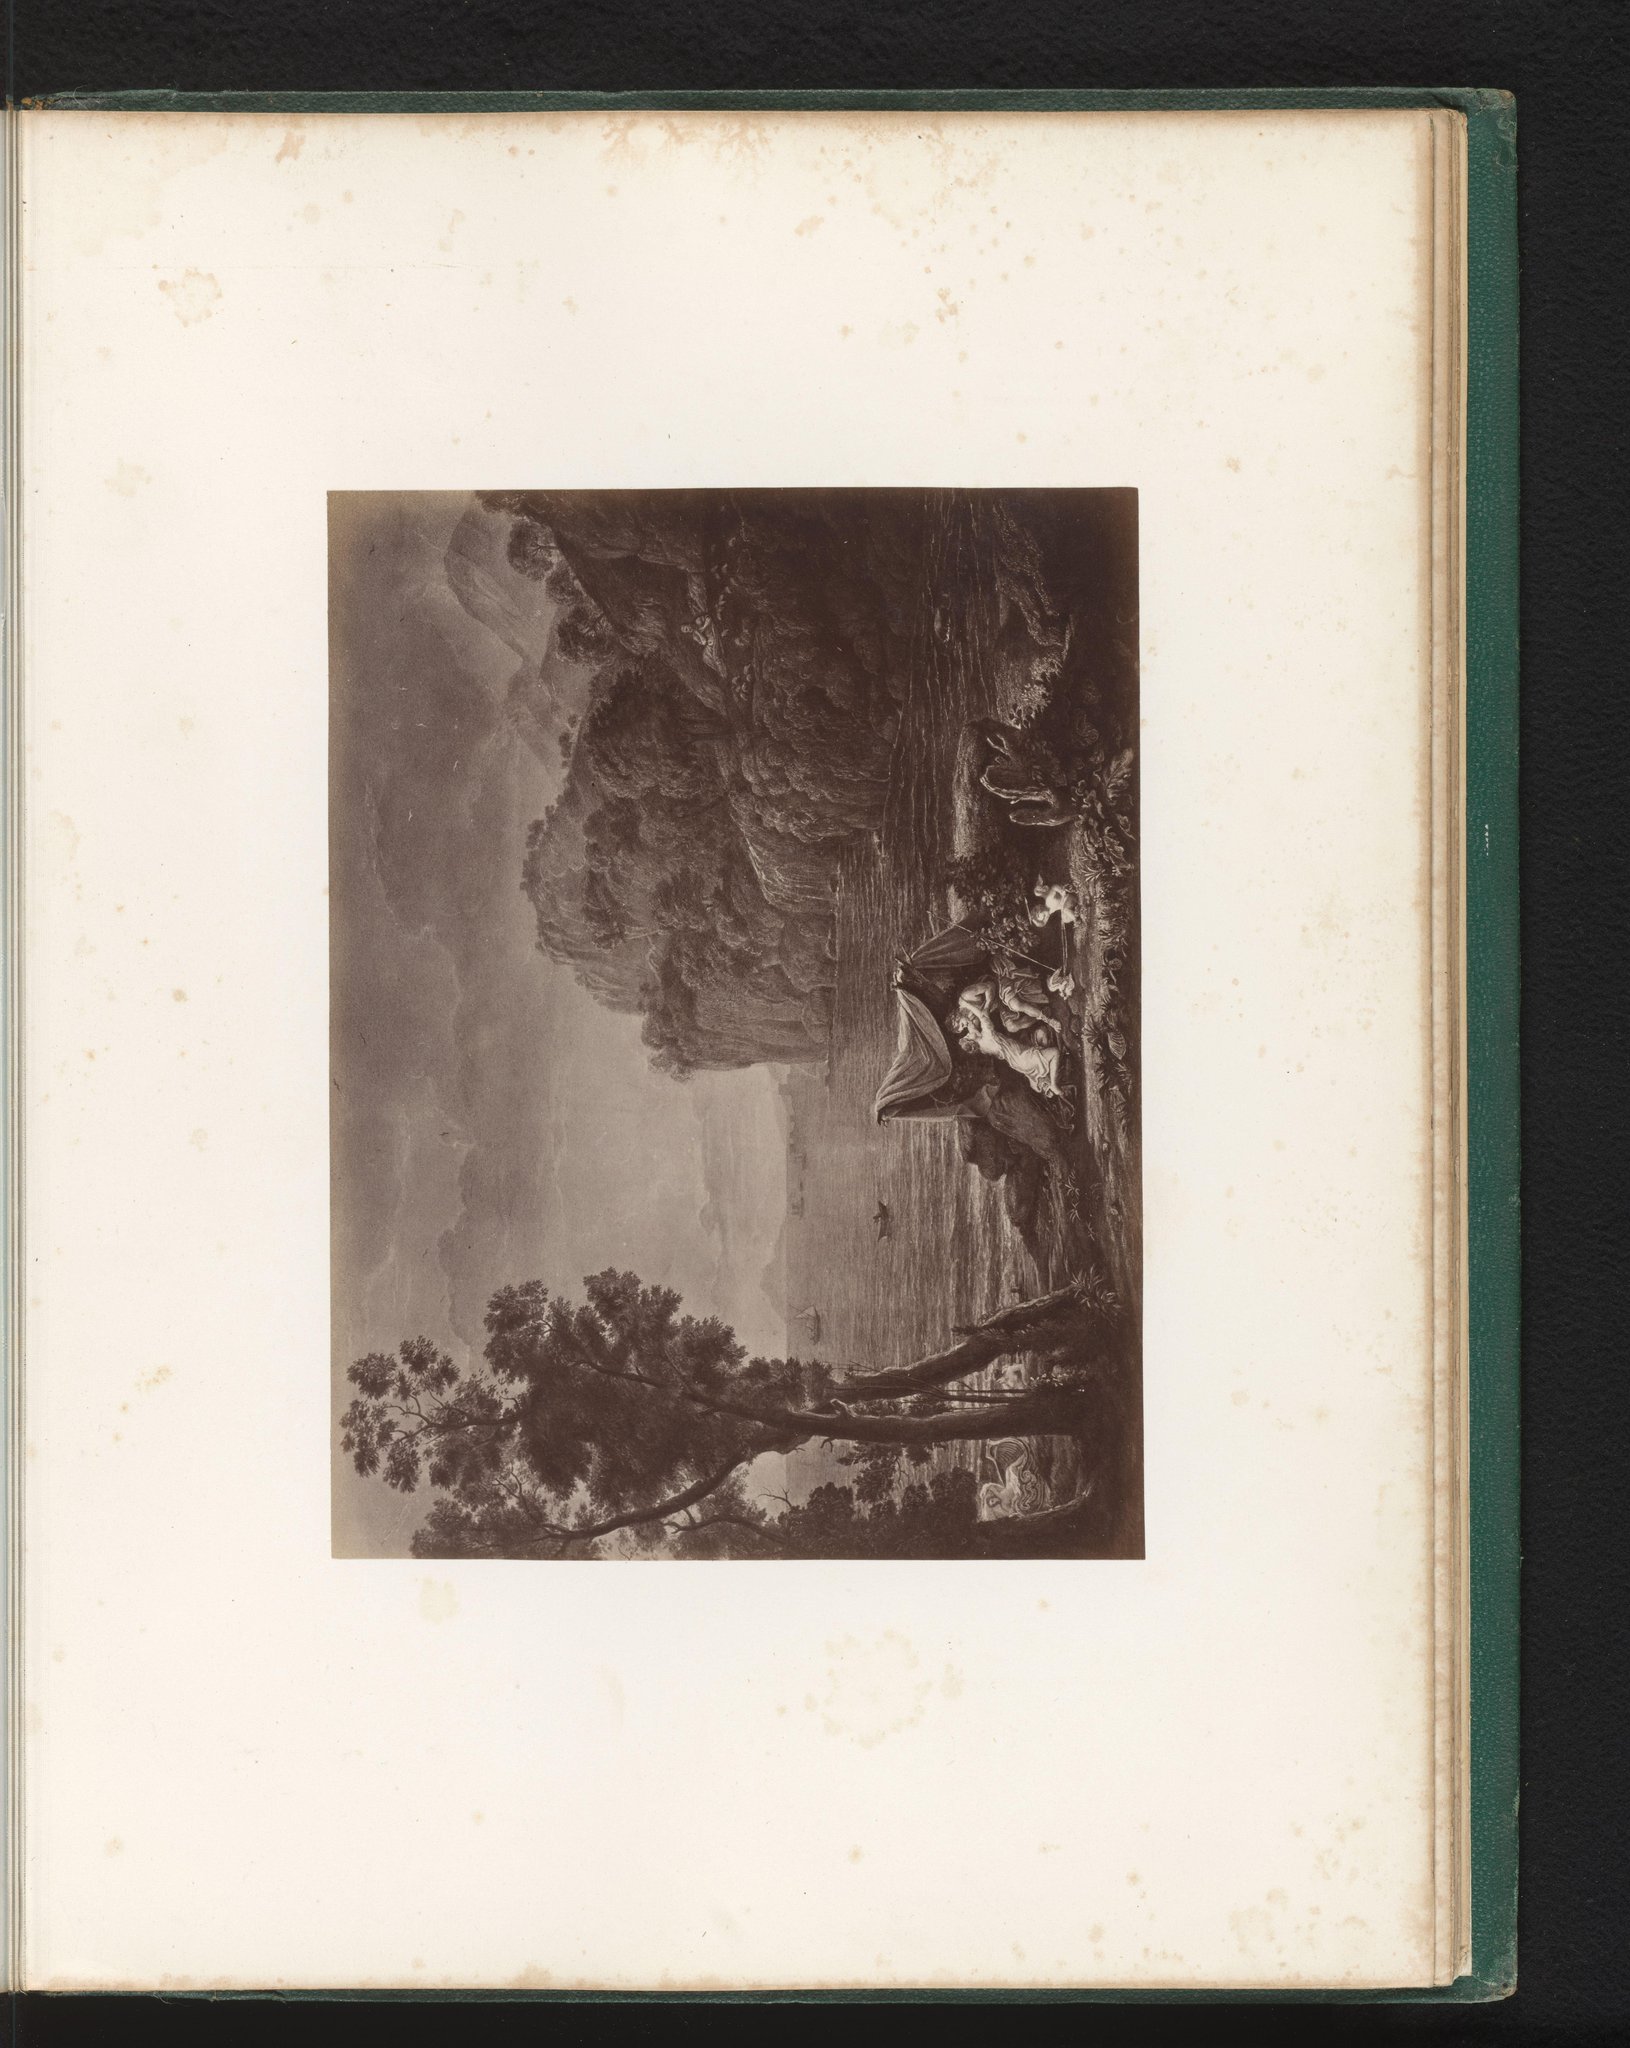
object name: reproduction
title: Claude Lorrain: Die Flucht nach Aegypten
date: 1870-1875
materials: paper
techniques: albumen print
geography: berlin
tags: flight into egypt and miracles during the journey